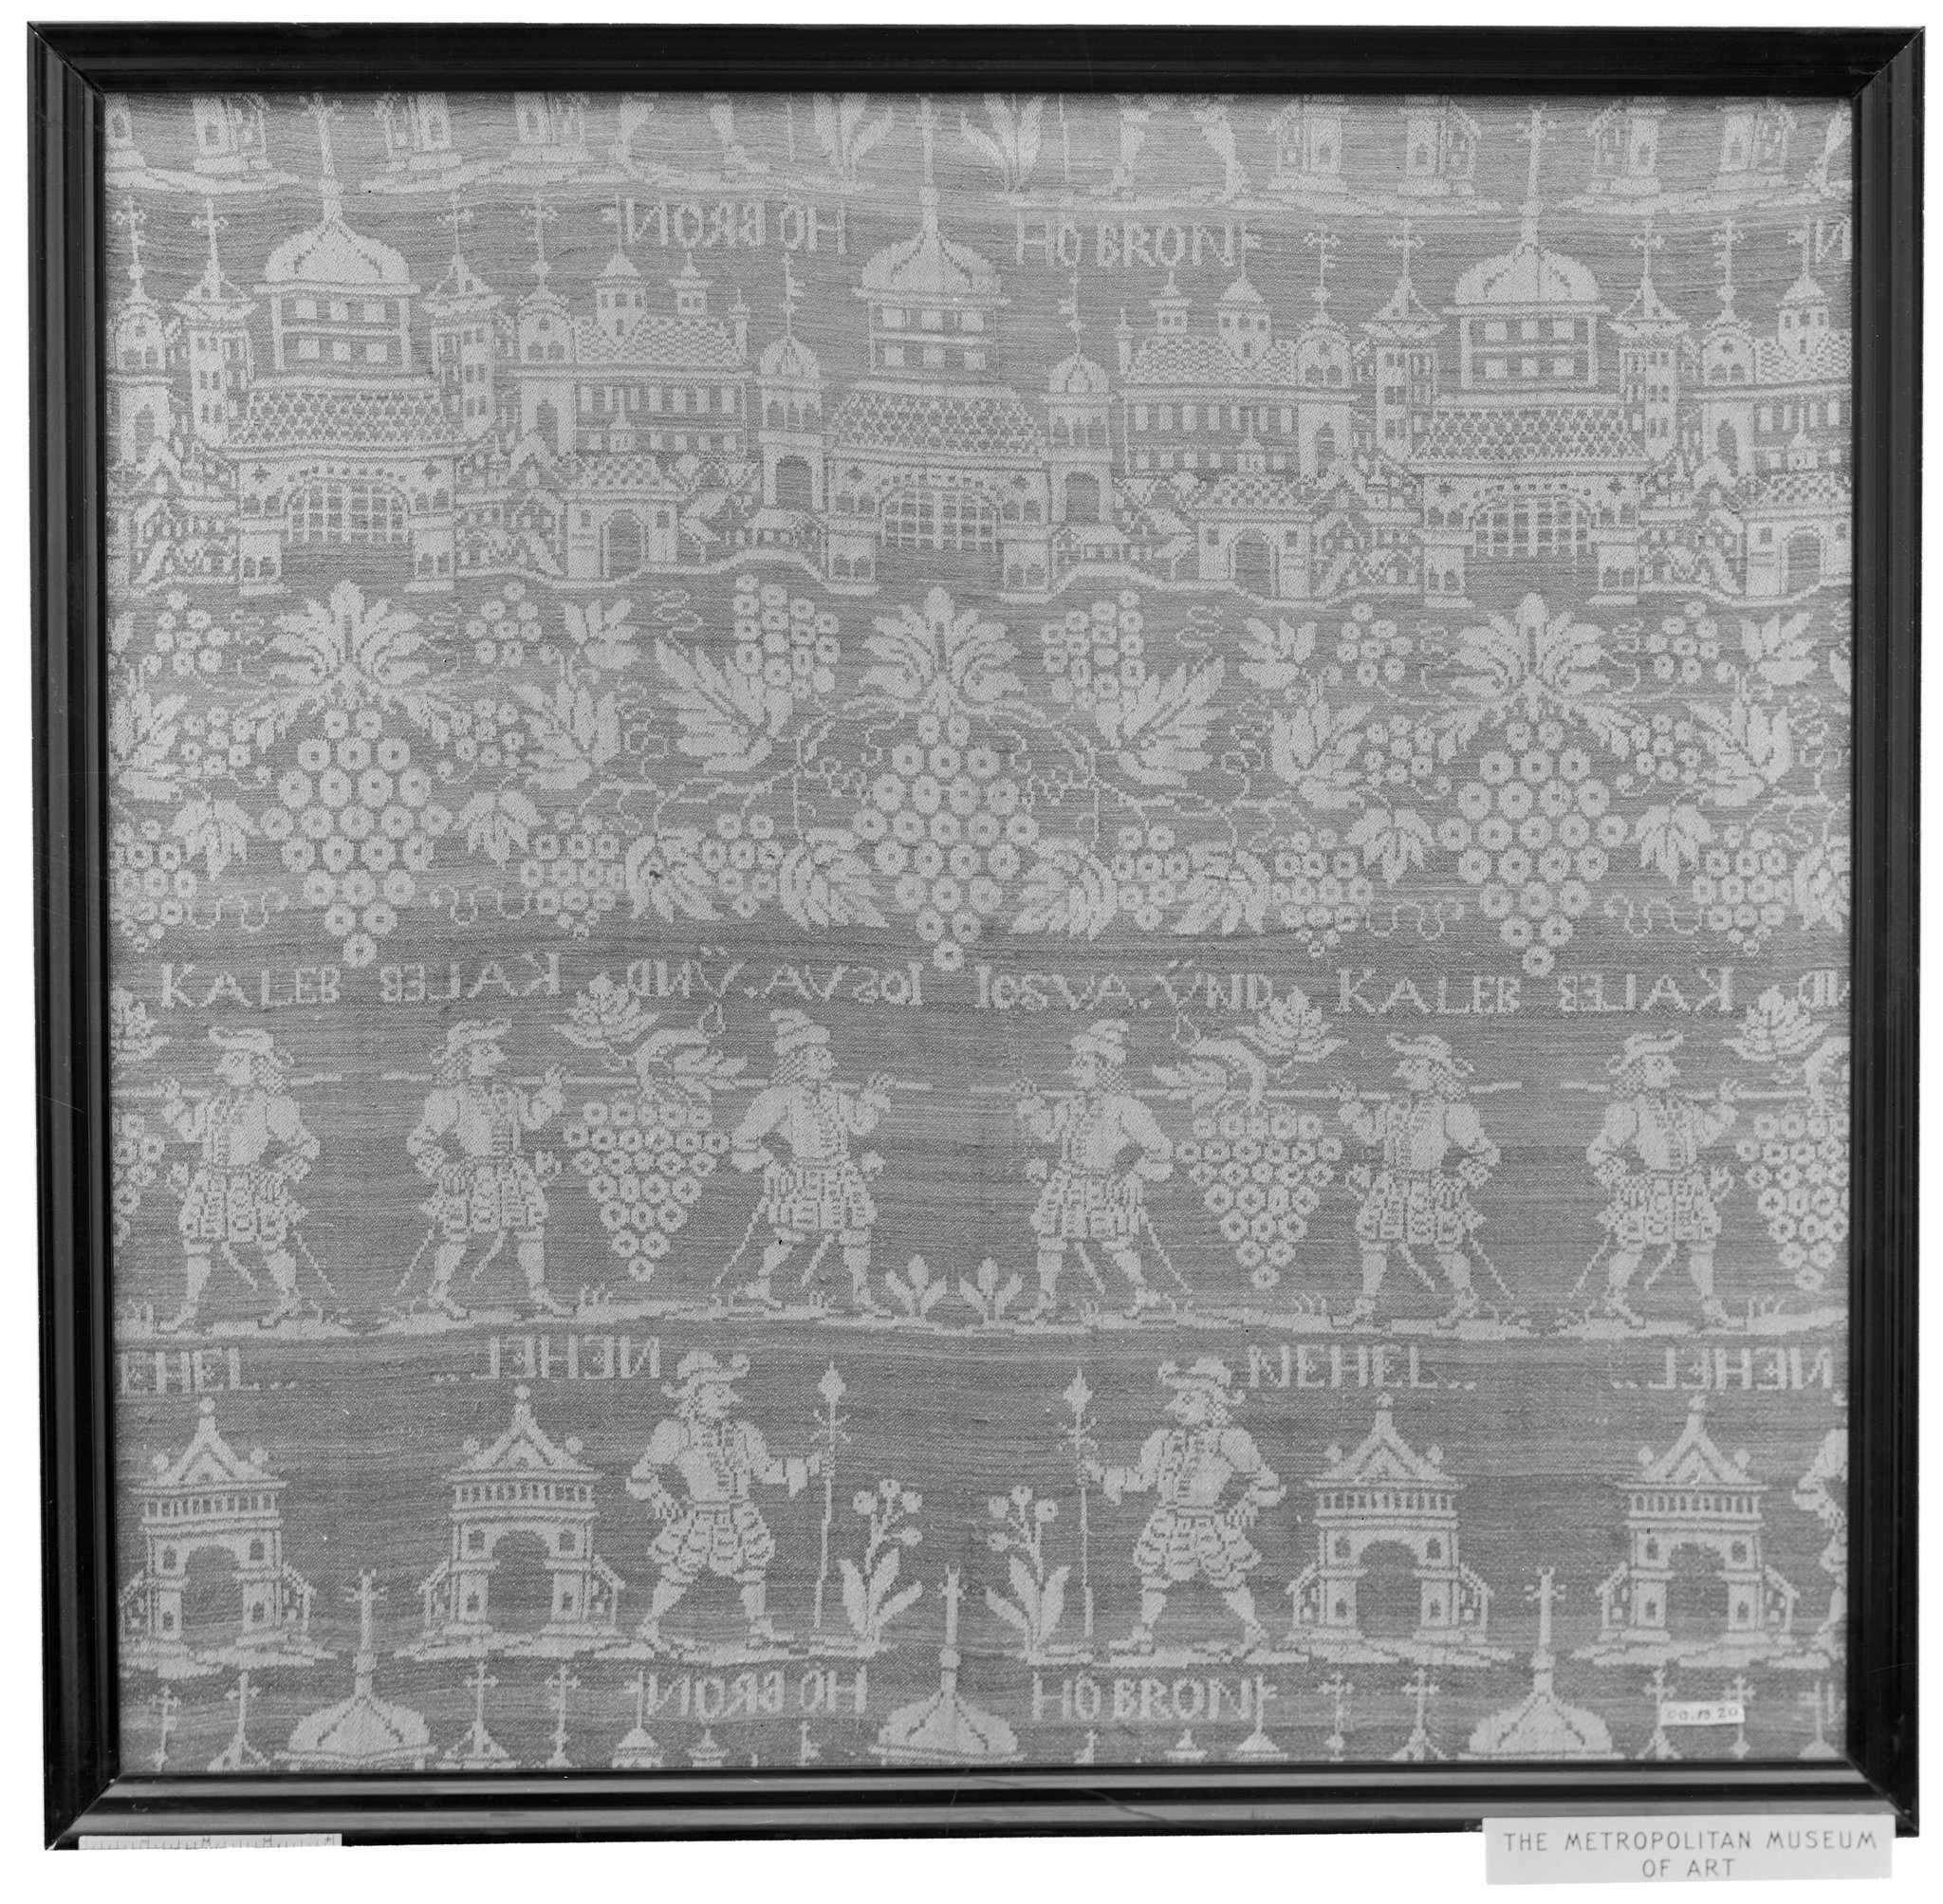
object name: piece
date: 1701-1800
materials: linen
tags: churches,spears,men,leaves